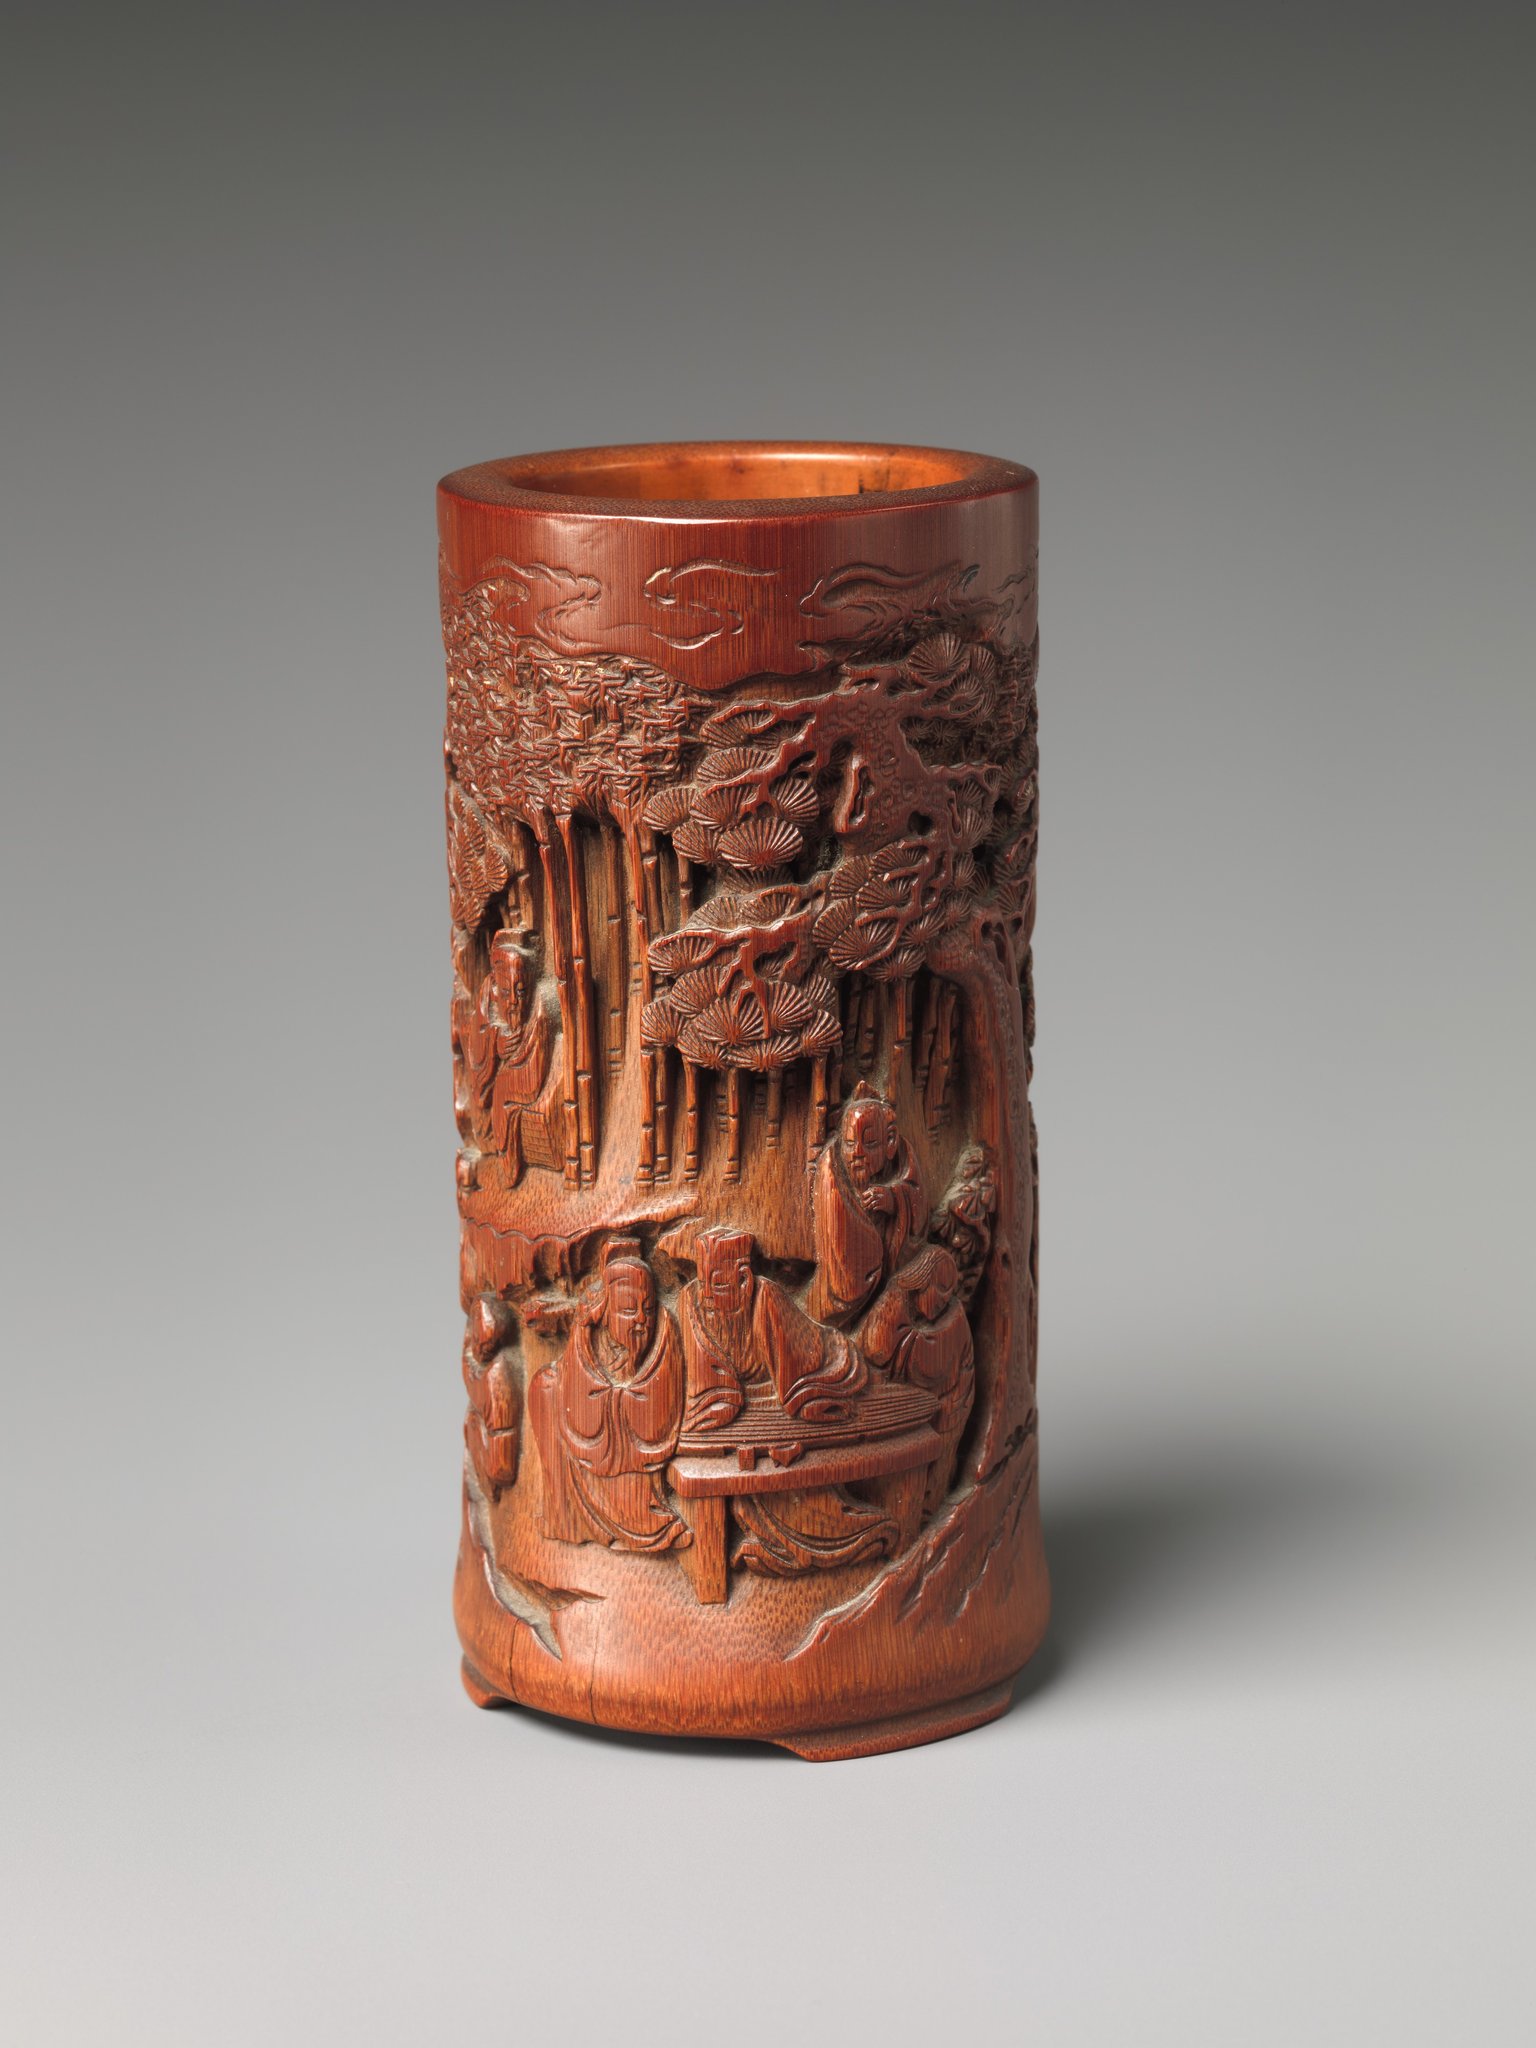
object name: brush holder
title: Brush holder with scholars in a garden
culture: chinese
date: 1767-1833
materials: bamboo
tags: men,bamboo,trees